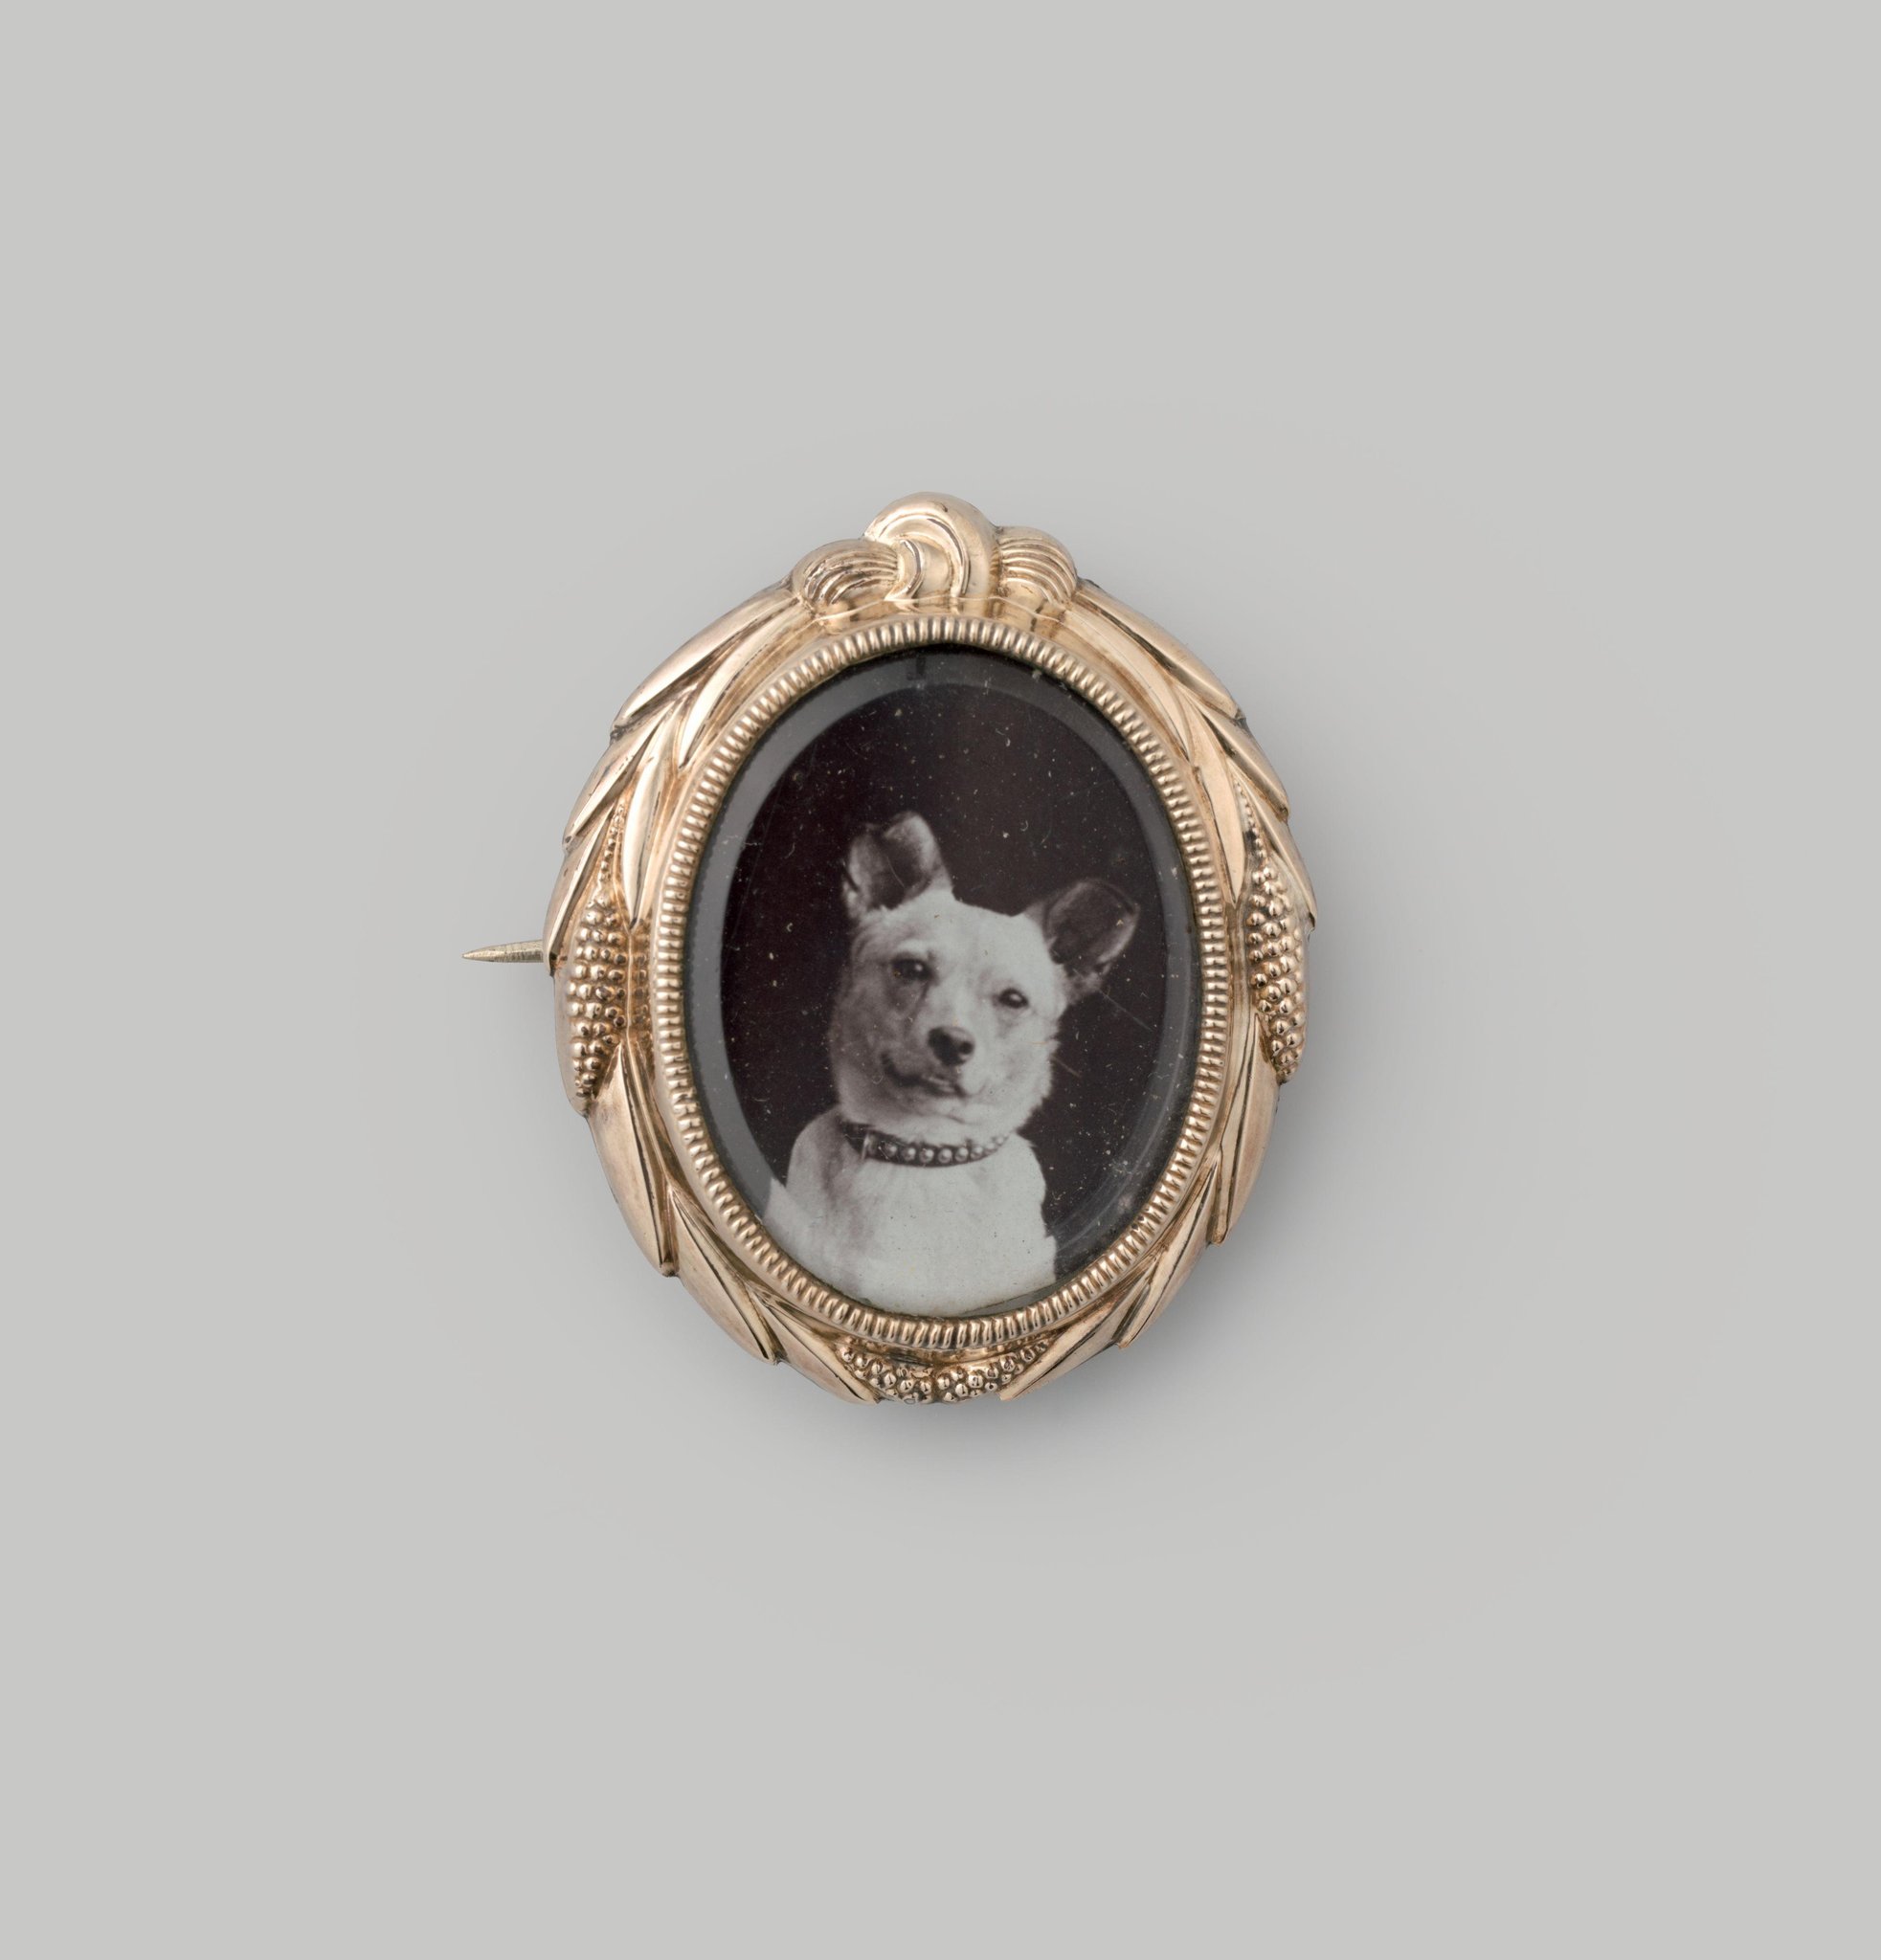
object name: brooch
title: Broche met foto van hond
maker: Anonymous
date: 1870-1890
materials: gold, silver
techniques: gelatin silver print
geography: northwest europe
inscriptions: duty mark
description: Broche van plaque d'or met foto van hond. De broche is voorzien van een haaksluiting.